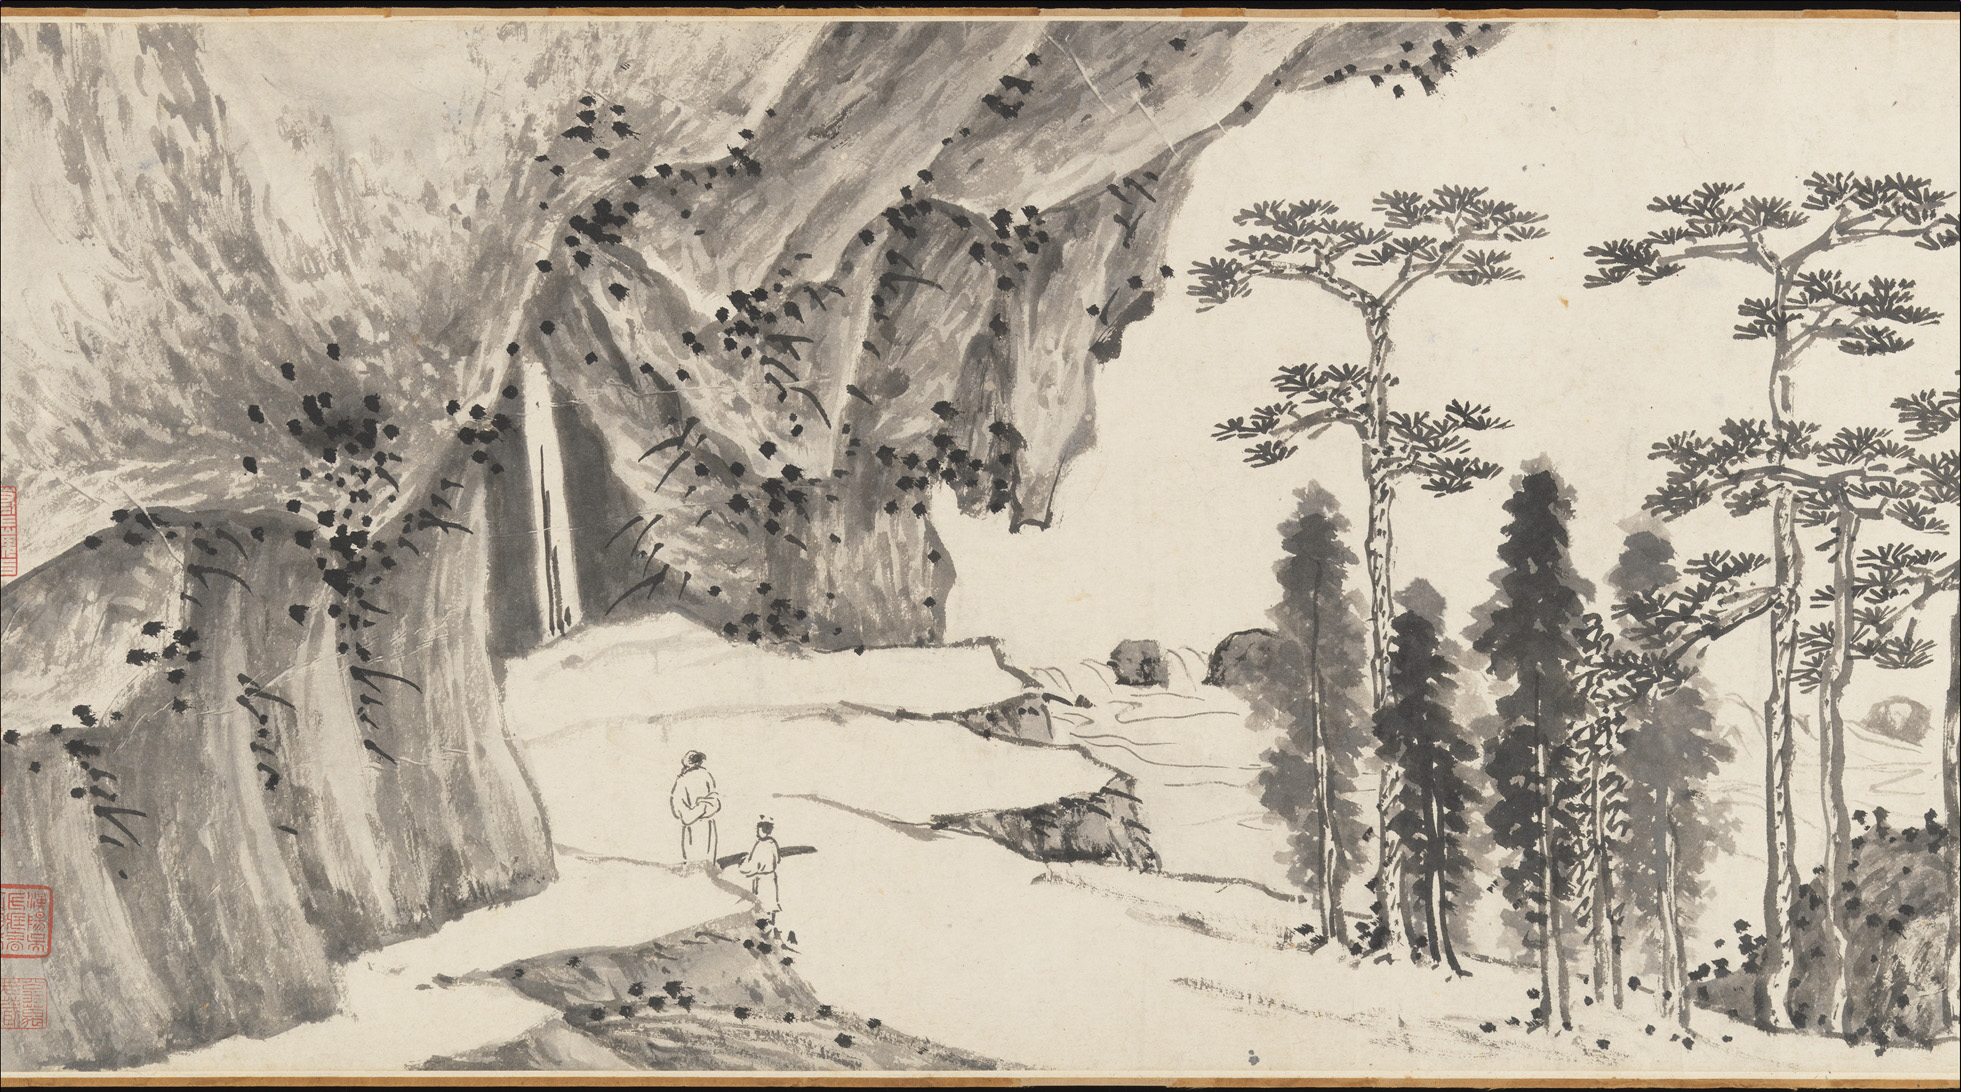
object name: handscroll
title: Joint Landscape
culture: chinese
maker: shen zhou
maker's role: artist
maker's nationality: chinese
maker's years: 1427-1509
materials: ink, paper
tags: landscapes